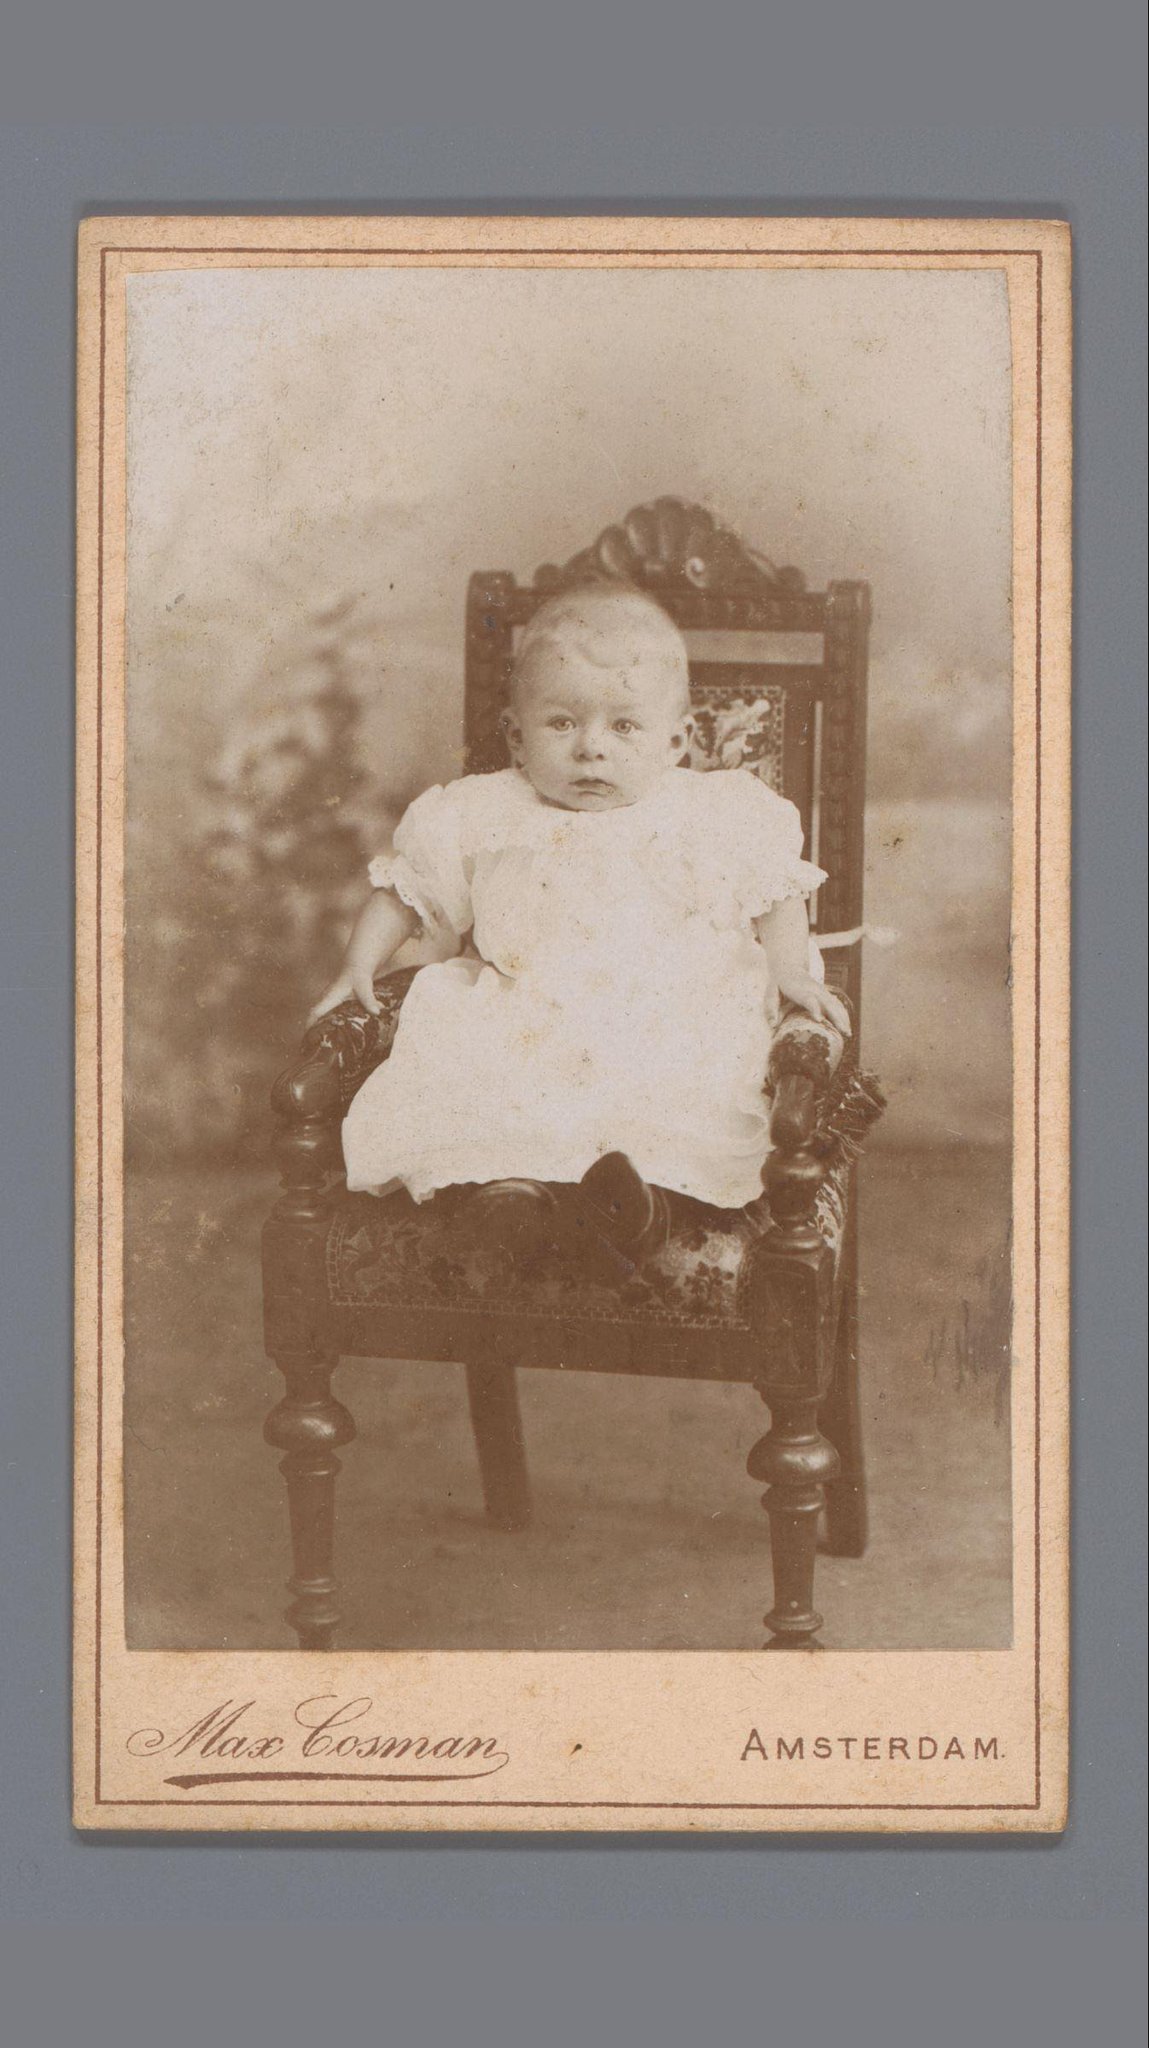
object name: photograph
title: Portret van een onbekende baby in stoel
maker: max cosman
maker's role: fotograaf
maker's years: 1852-1894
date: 1881-1903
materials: paper, cardboard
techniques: collodion silver print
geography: amsterdam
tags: anonymous historical person portrayed, infant, baby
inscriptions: inscription: ‘Specialiteit in vergrootingen./ BLOCK & Co, BERLIN, S.W.’, address: ‘Galerij 48/ Amsterdam.’